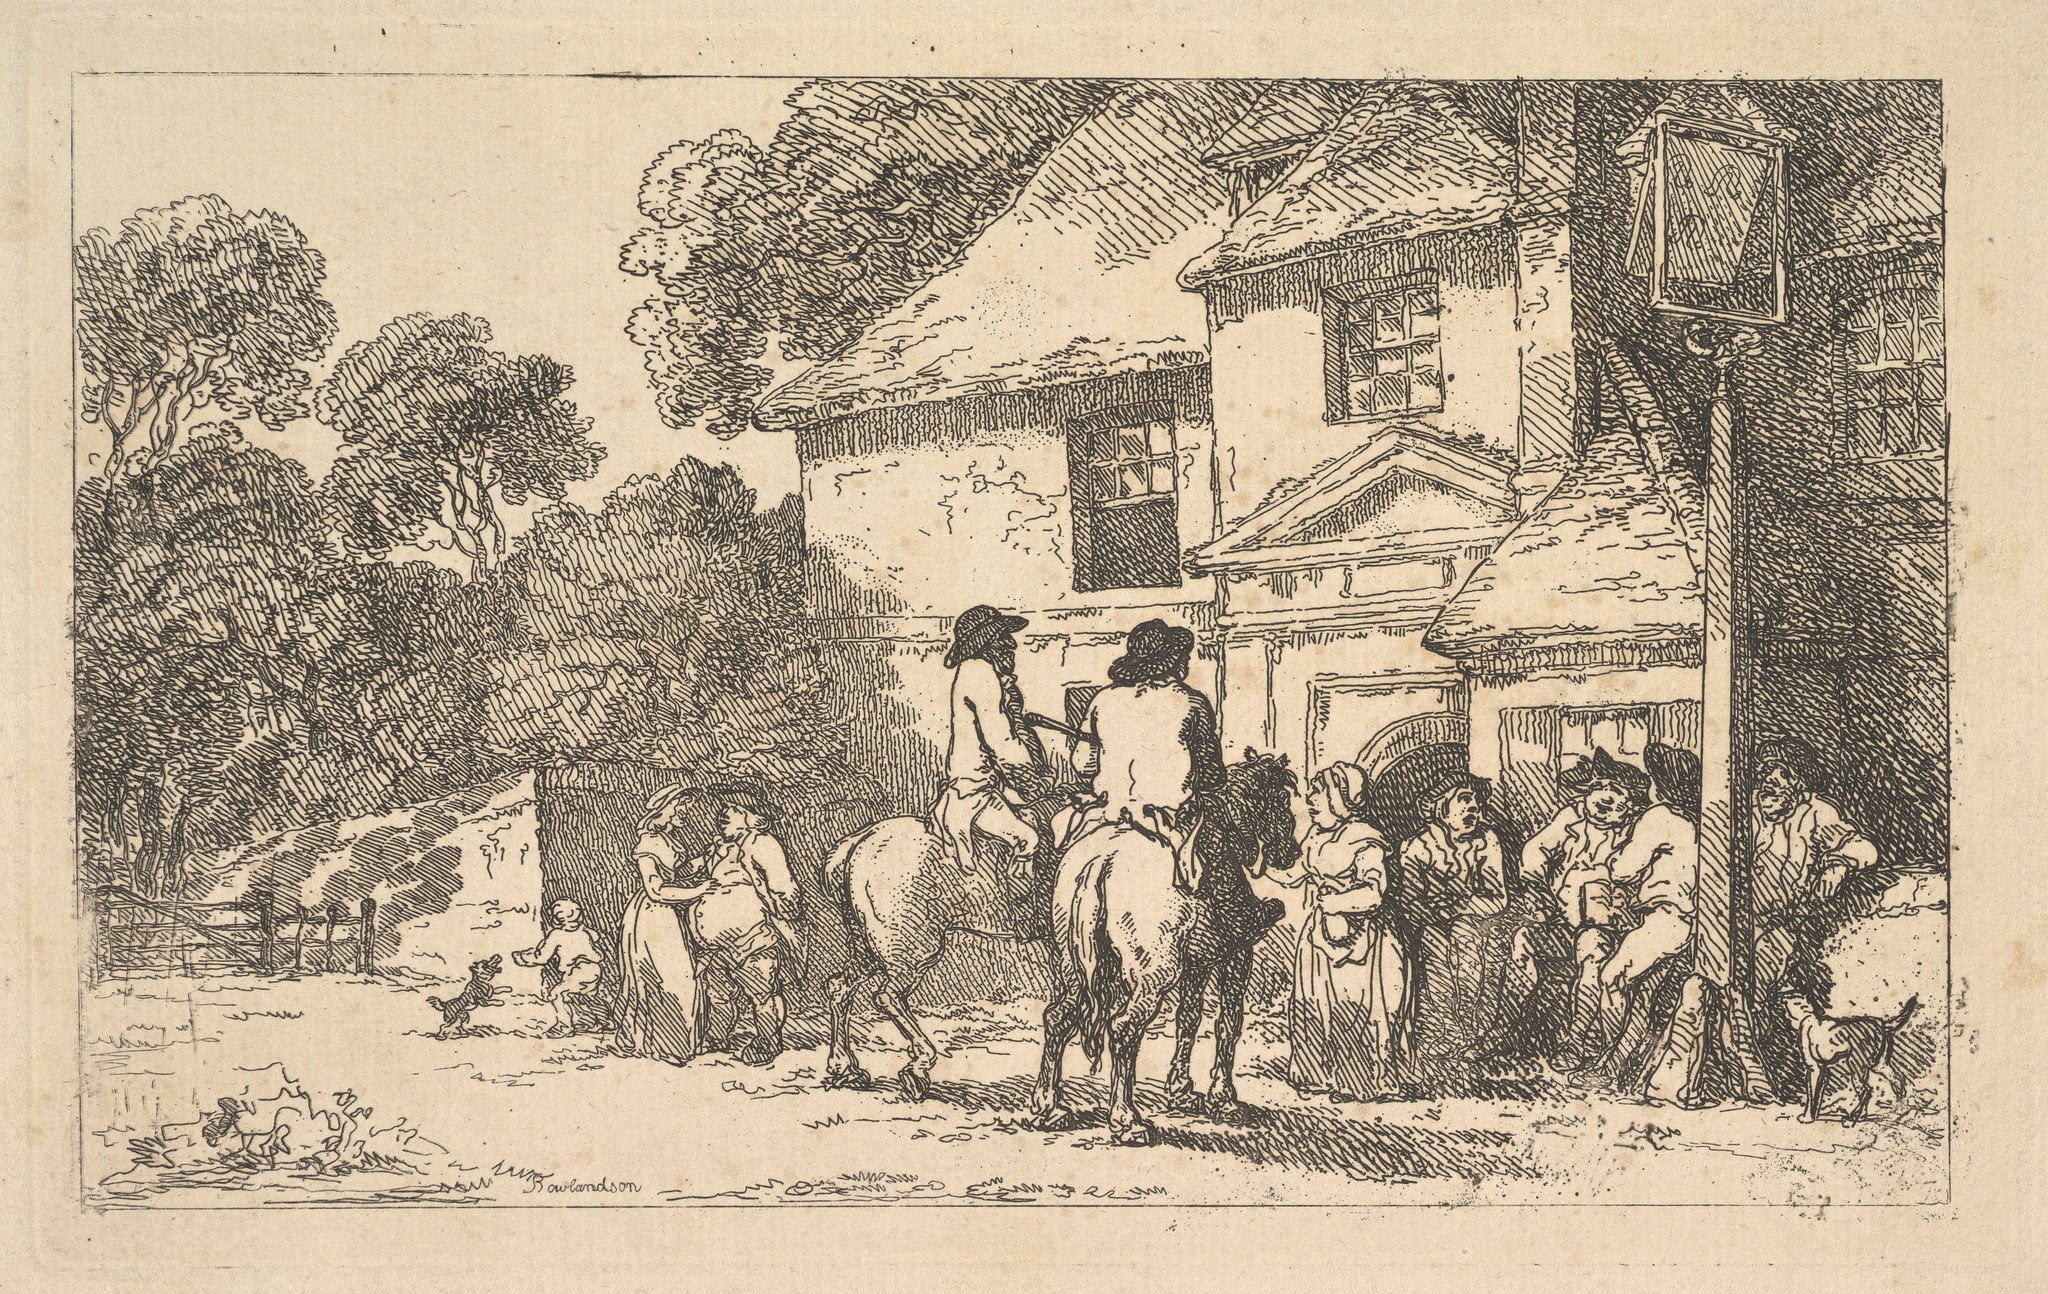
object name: print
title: The Three Horseshoes, a Roadside Inn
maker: thomas rowlandson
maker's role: artist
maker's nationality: british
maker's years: 1757-1827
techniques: etching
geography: england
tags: inns,men,women,horses